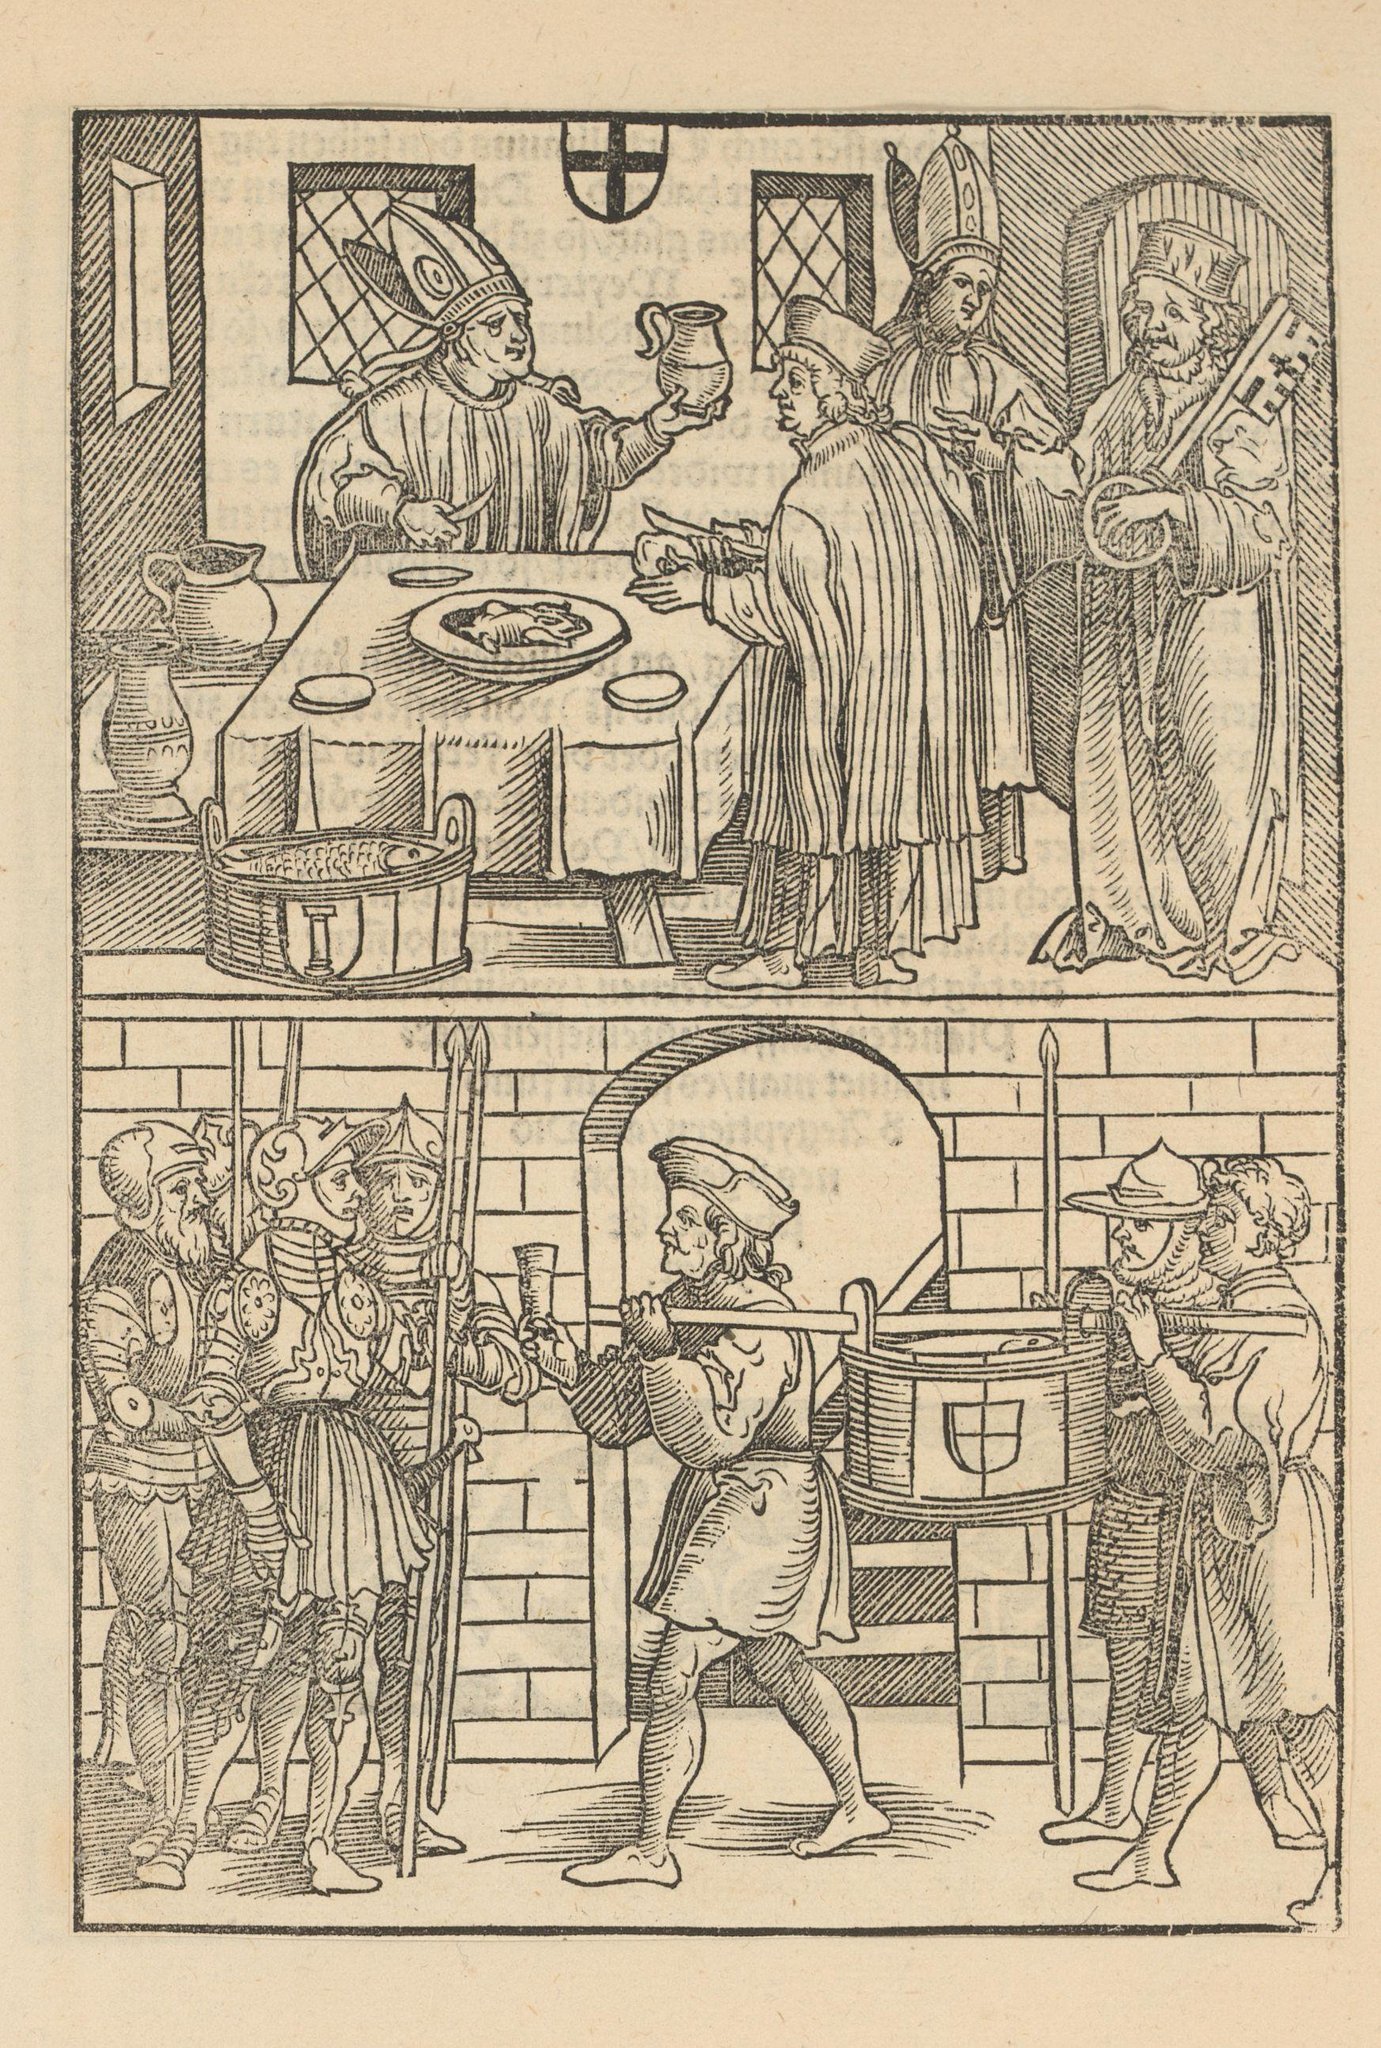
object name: book illustration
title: Geestelijken aan tafel en een voorstelling van soldaten en mannen die een vat dragen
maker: Anonymous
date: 1490-1536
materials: paper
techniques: letterpress printing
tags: carrying something with carrying-pole, eating of blessed food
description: Prent is gebruikt in: Reichenthal, Ulrich von. Reichenthal Das Concilium so zu Constantz Gehalten ist Worden (...). Augsburg: Heinrich Steiner, 1536.